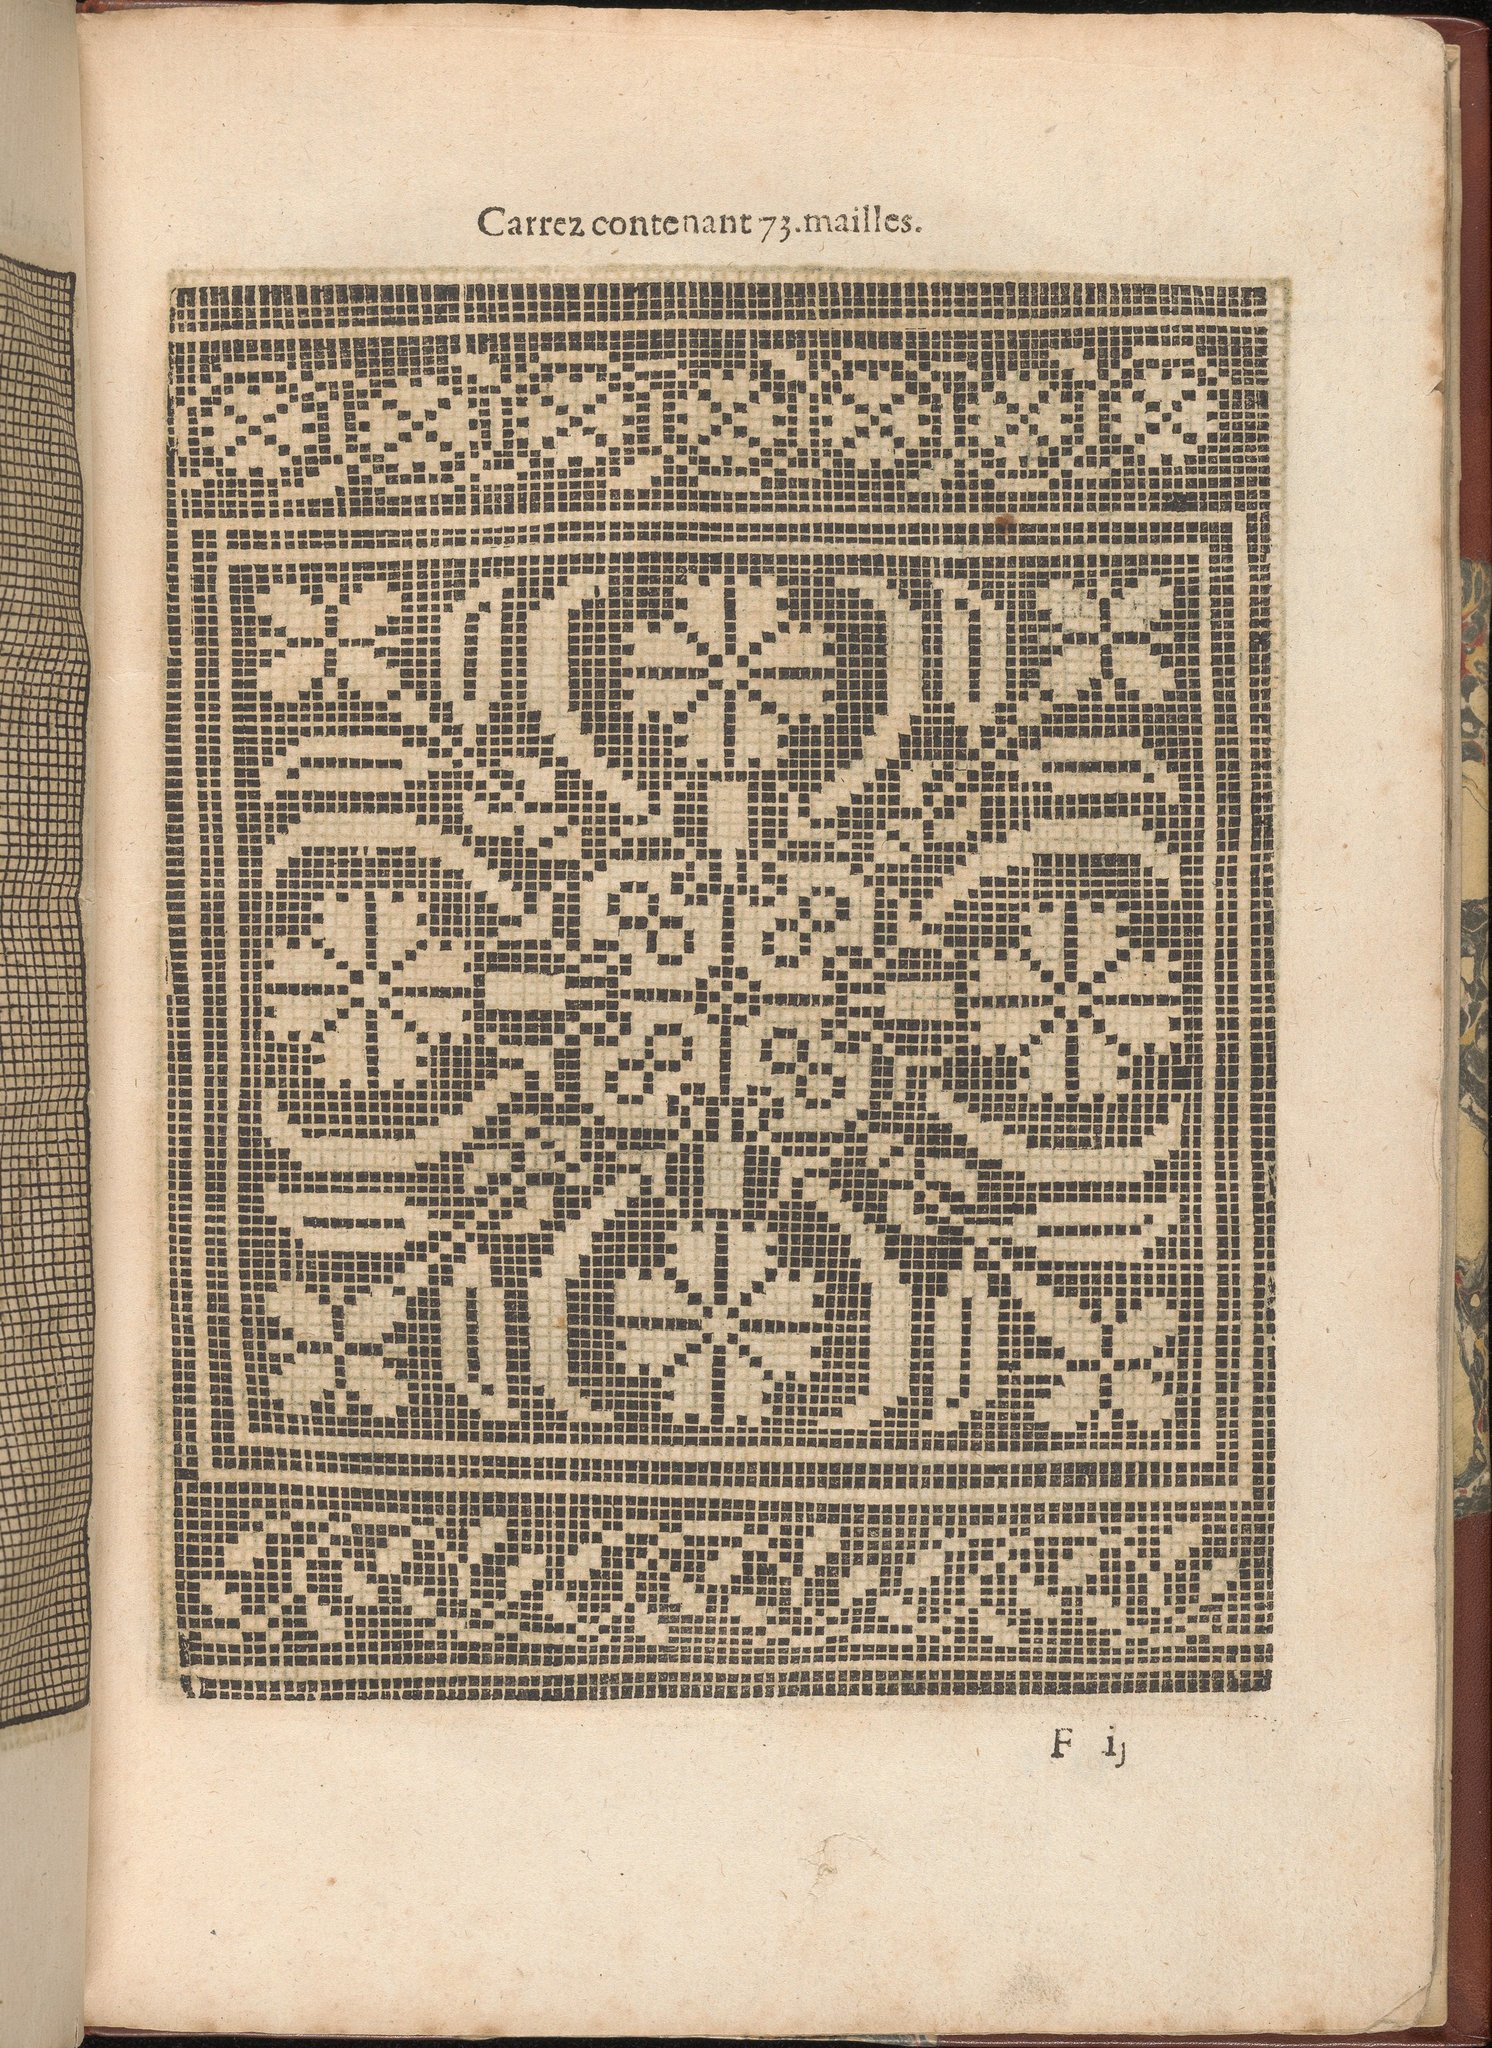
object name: book print ornament architecture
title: Les Secondes Oeuvres, et Subtiles Inventions De Lingerie du Seigneur Federic de Vinciolo Venitien, page 22 (recto)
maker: federico de vinciolo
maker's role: designer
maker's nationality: italian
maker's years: 1582-1599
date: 1603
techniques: woodcut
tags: flowers